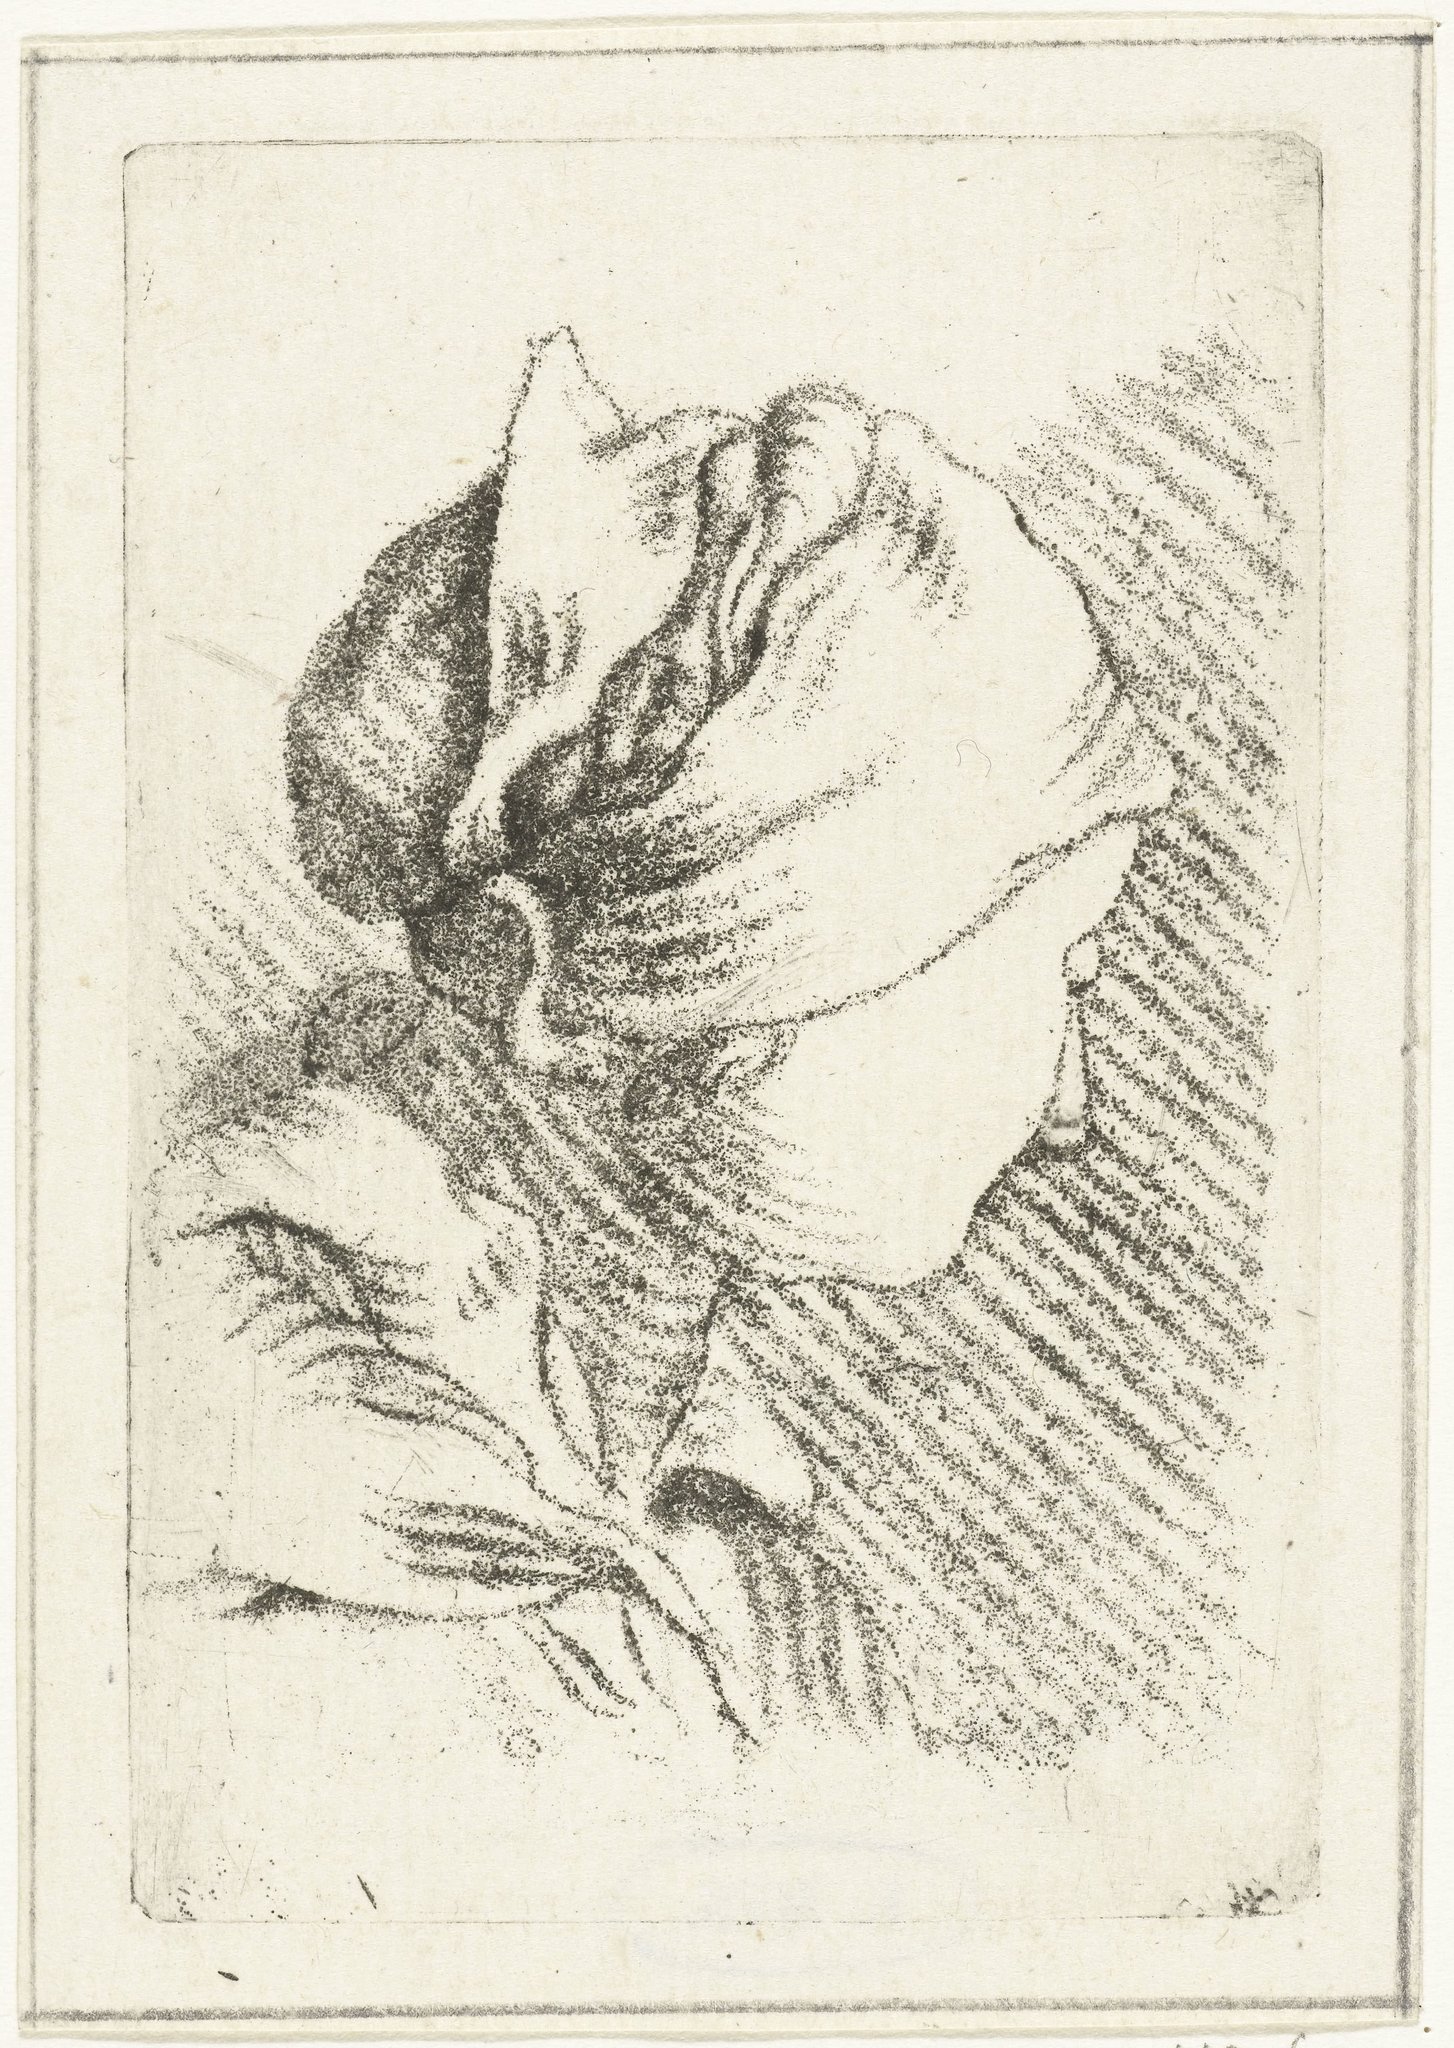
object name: print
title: Studieblad met een vrouwenhoofd met hoofddoek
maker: louis bernard coclers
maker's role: draughtsman, print maker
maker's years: 1741-1817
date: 1756-1817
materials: paper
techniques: printmaking, etching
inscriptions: collector's mark: Lugt 2228